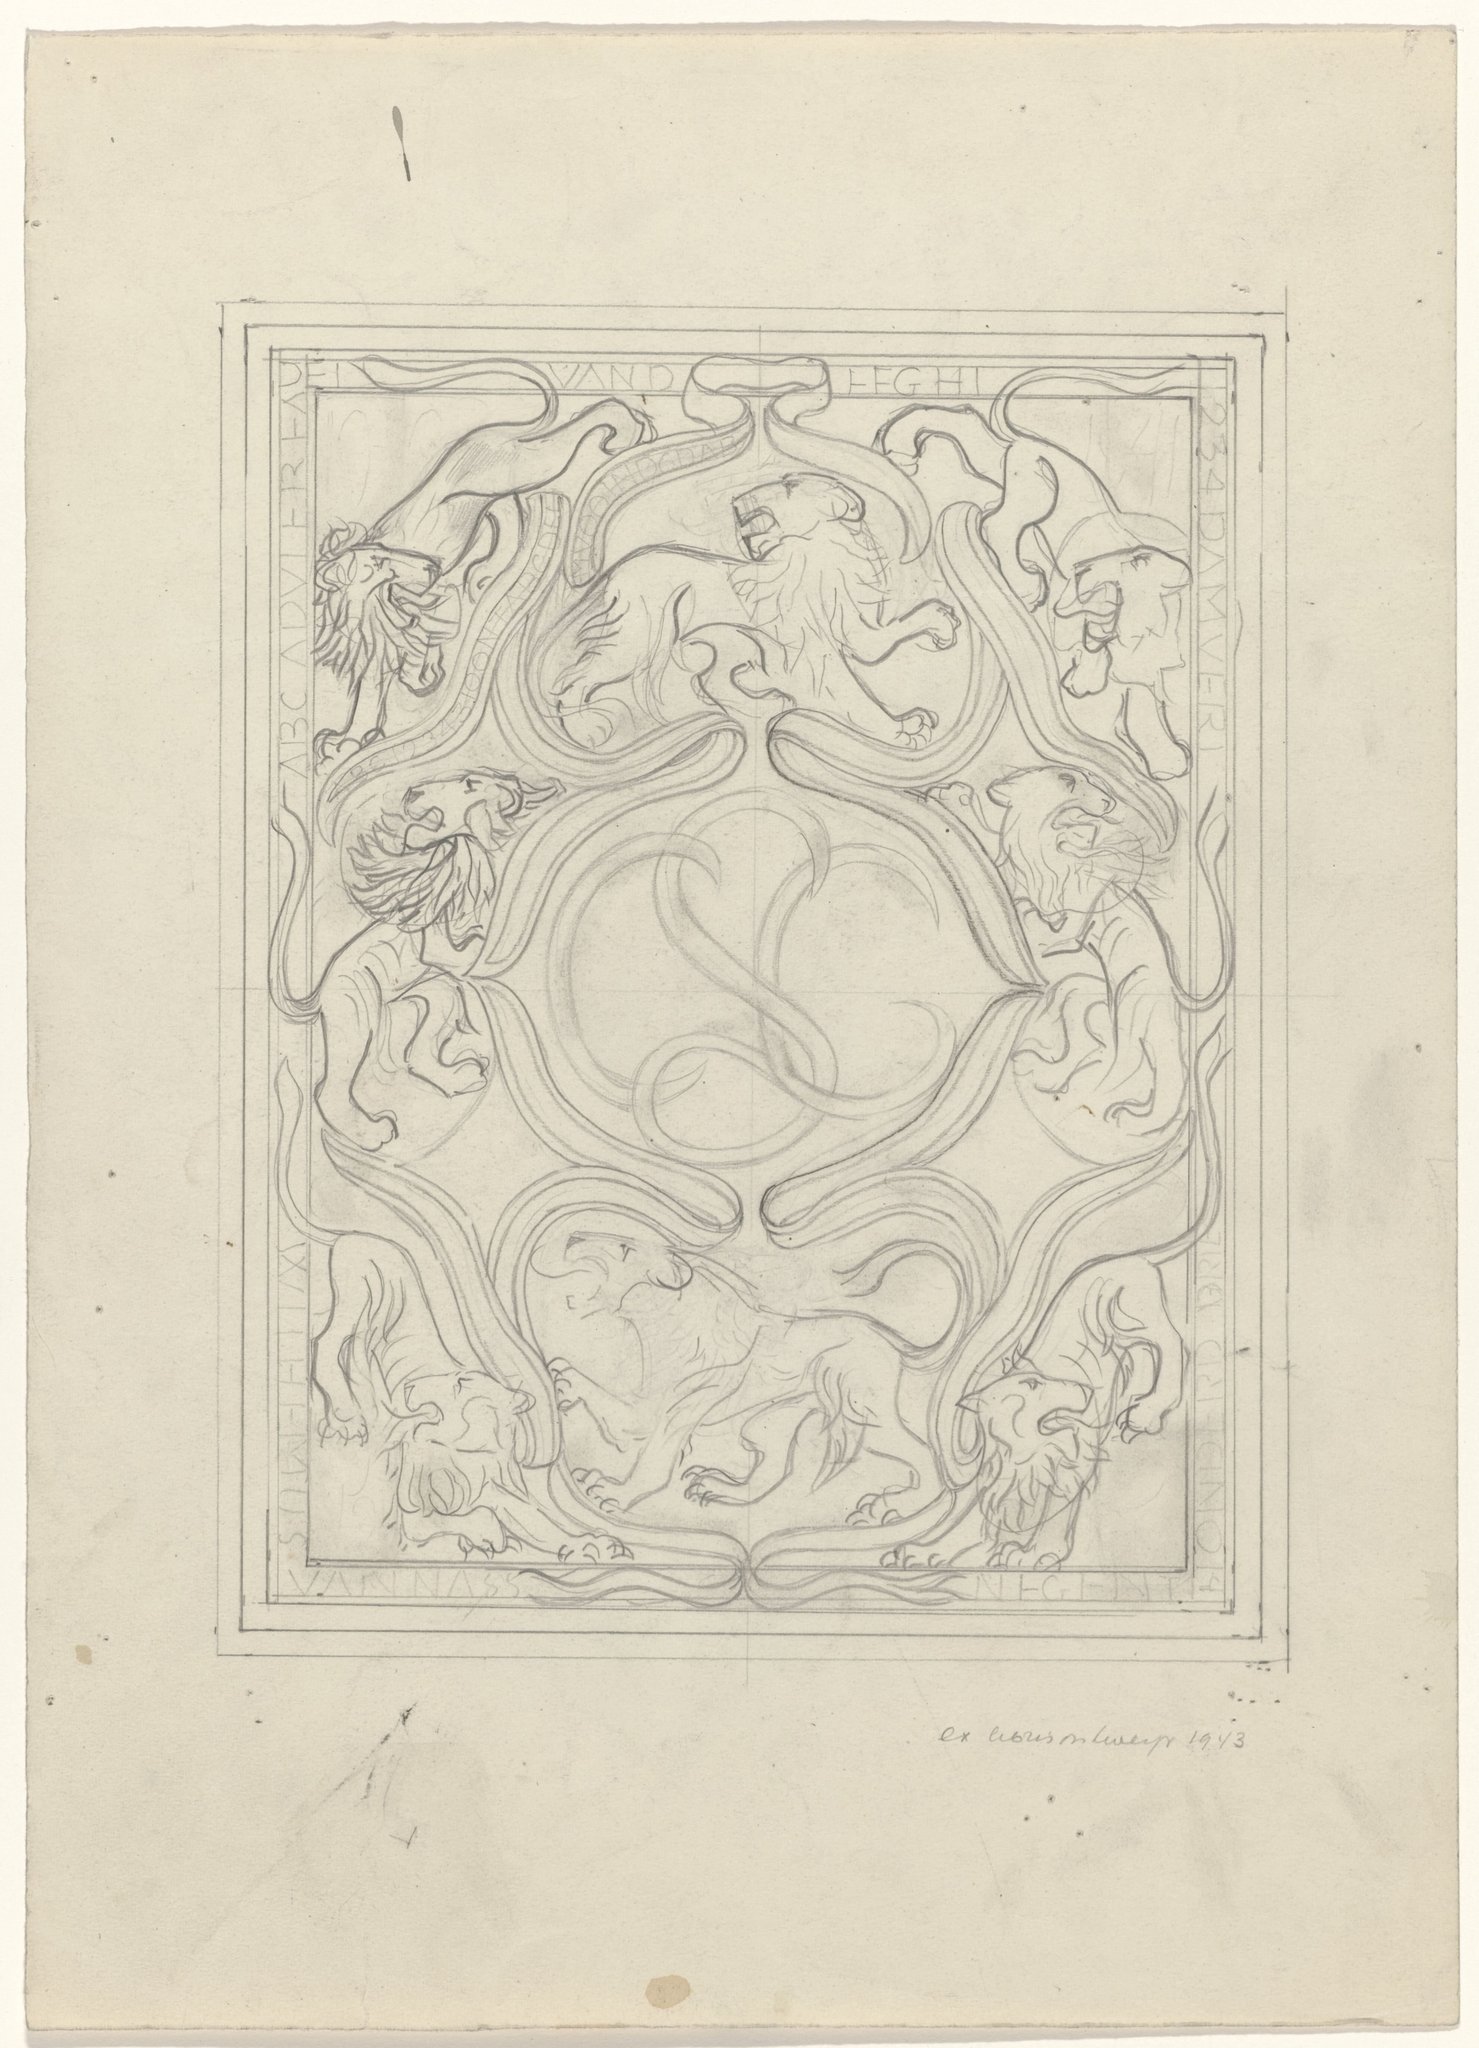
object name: drawing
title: Ontwerp voor een ex libris voor de zoon van de kunstenaar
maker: carel adolph lion cachet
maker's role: draughtsman, print maker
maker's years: 1864-1945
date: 1874-1945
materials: paper, pencil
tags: ornament derived from animal forms, ex-libris, beasts of prey, predatory animals: lion, letter combinations such as letterword, anagram, letter square, monogram, etc.